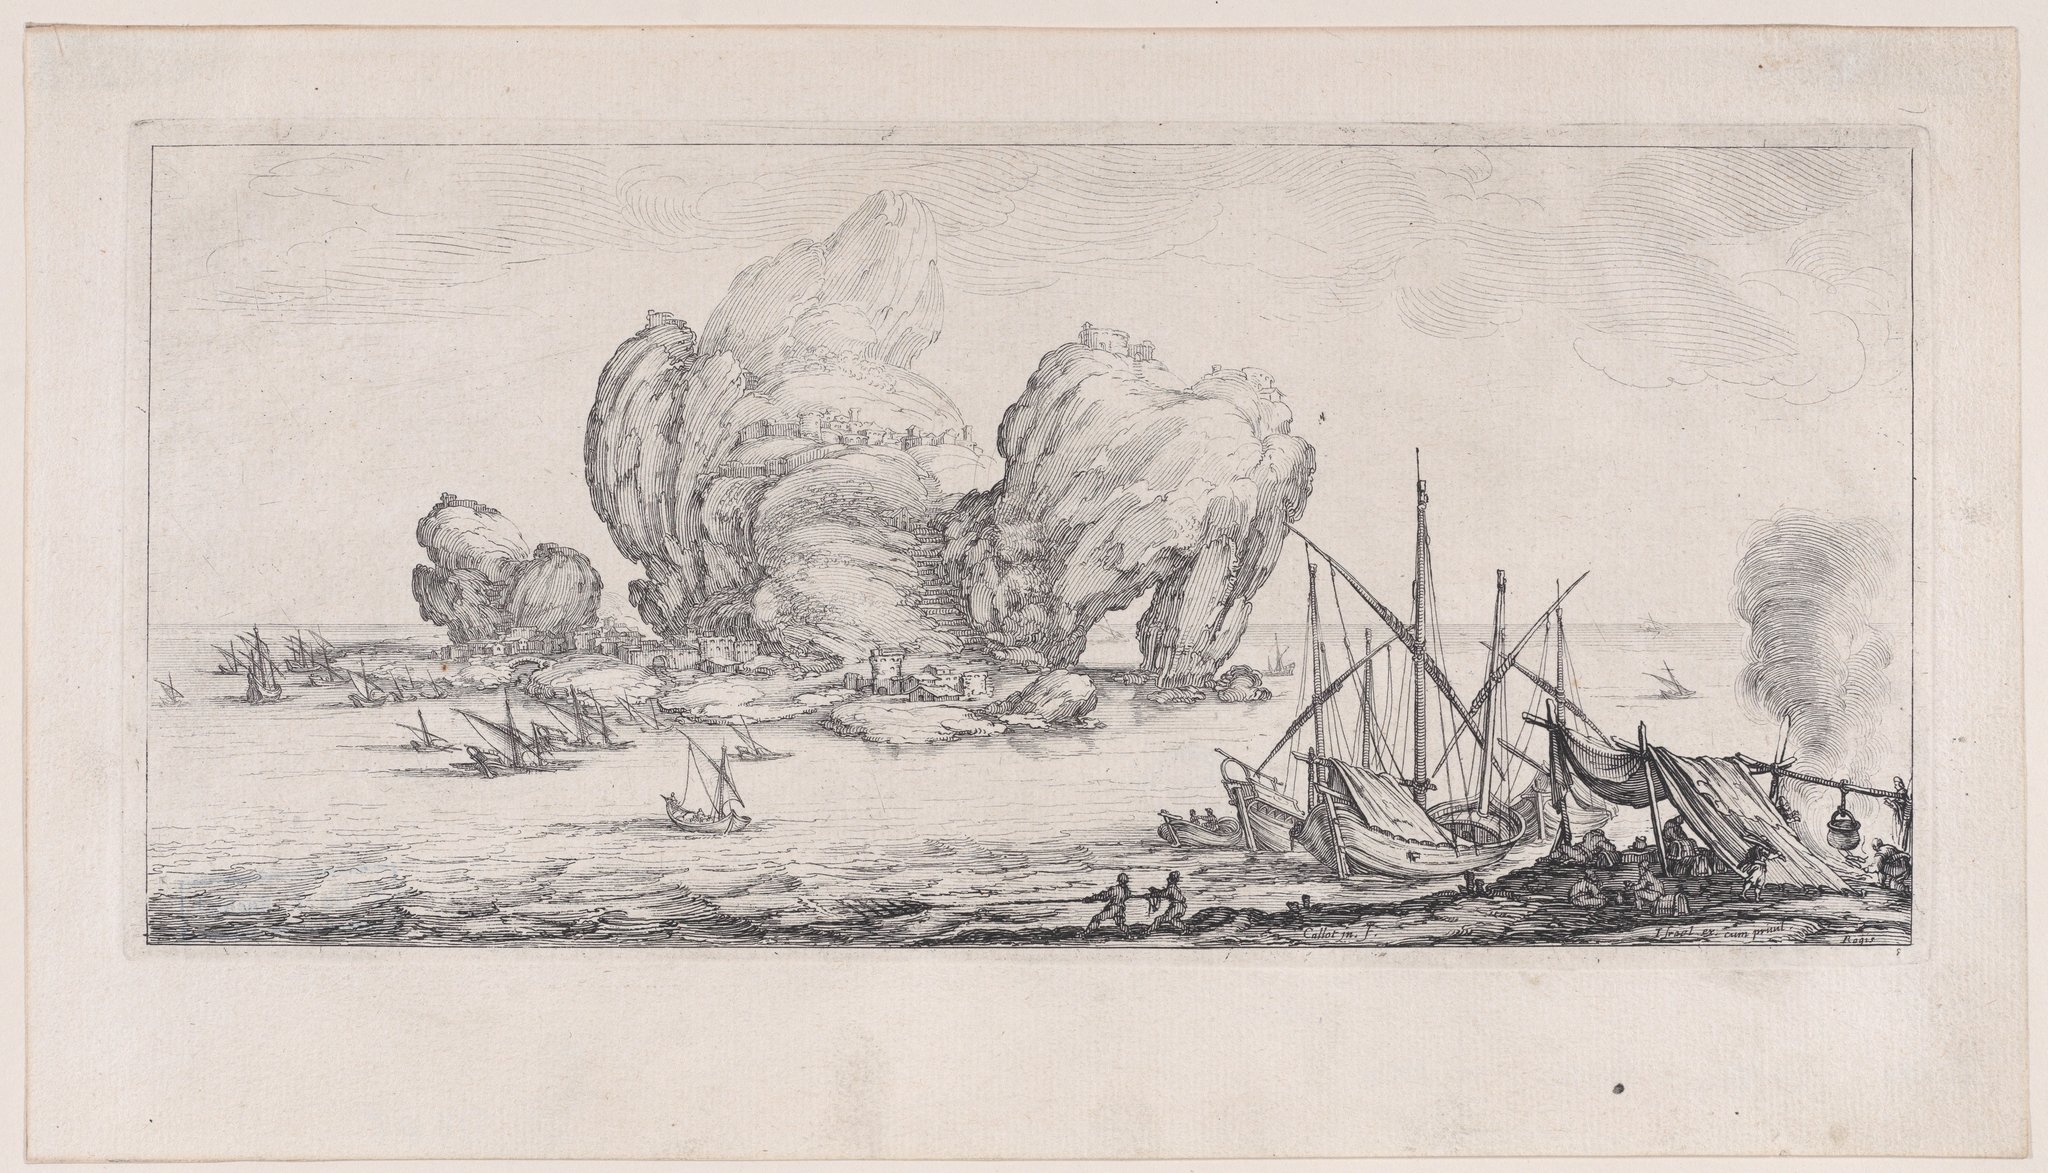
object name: print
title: Le Grand Rocher (The Large Rock), from "Paysages Gravés pour Jean de Médicis appelées aussi Paysages Dessinés a Florence, Vues de Florence, Paysages d'Italie, et Paysages Définitifs" (Landscapes Engraved for Giovanni de'Medici, Landscapes Designed in Florence, Views of Florence, Landscapes of Italy, and Definitive Landscapes)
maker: jacques callot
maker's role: artist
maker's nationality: french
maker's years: 1592-1635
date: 1618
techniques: etching